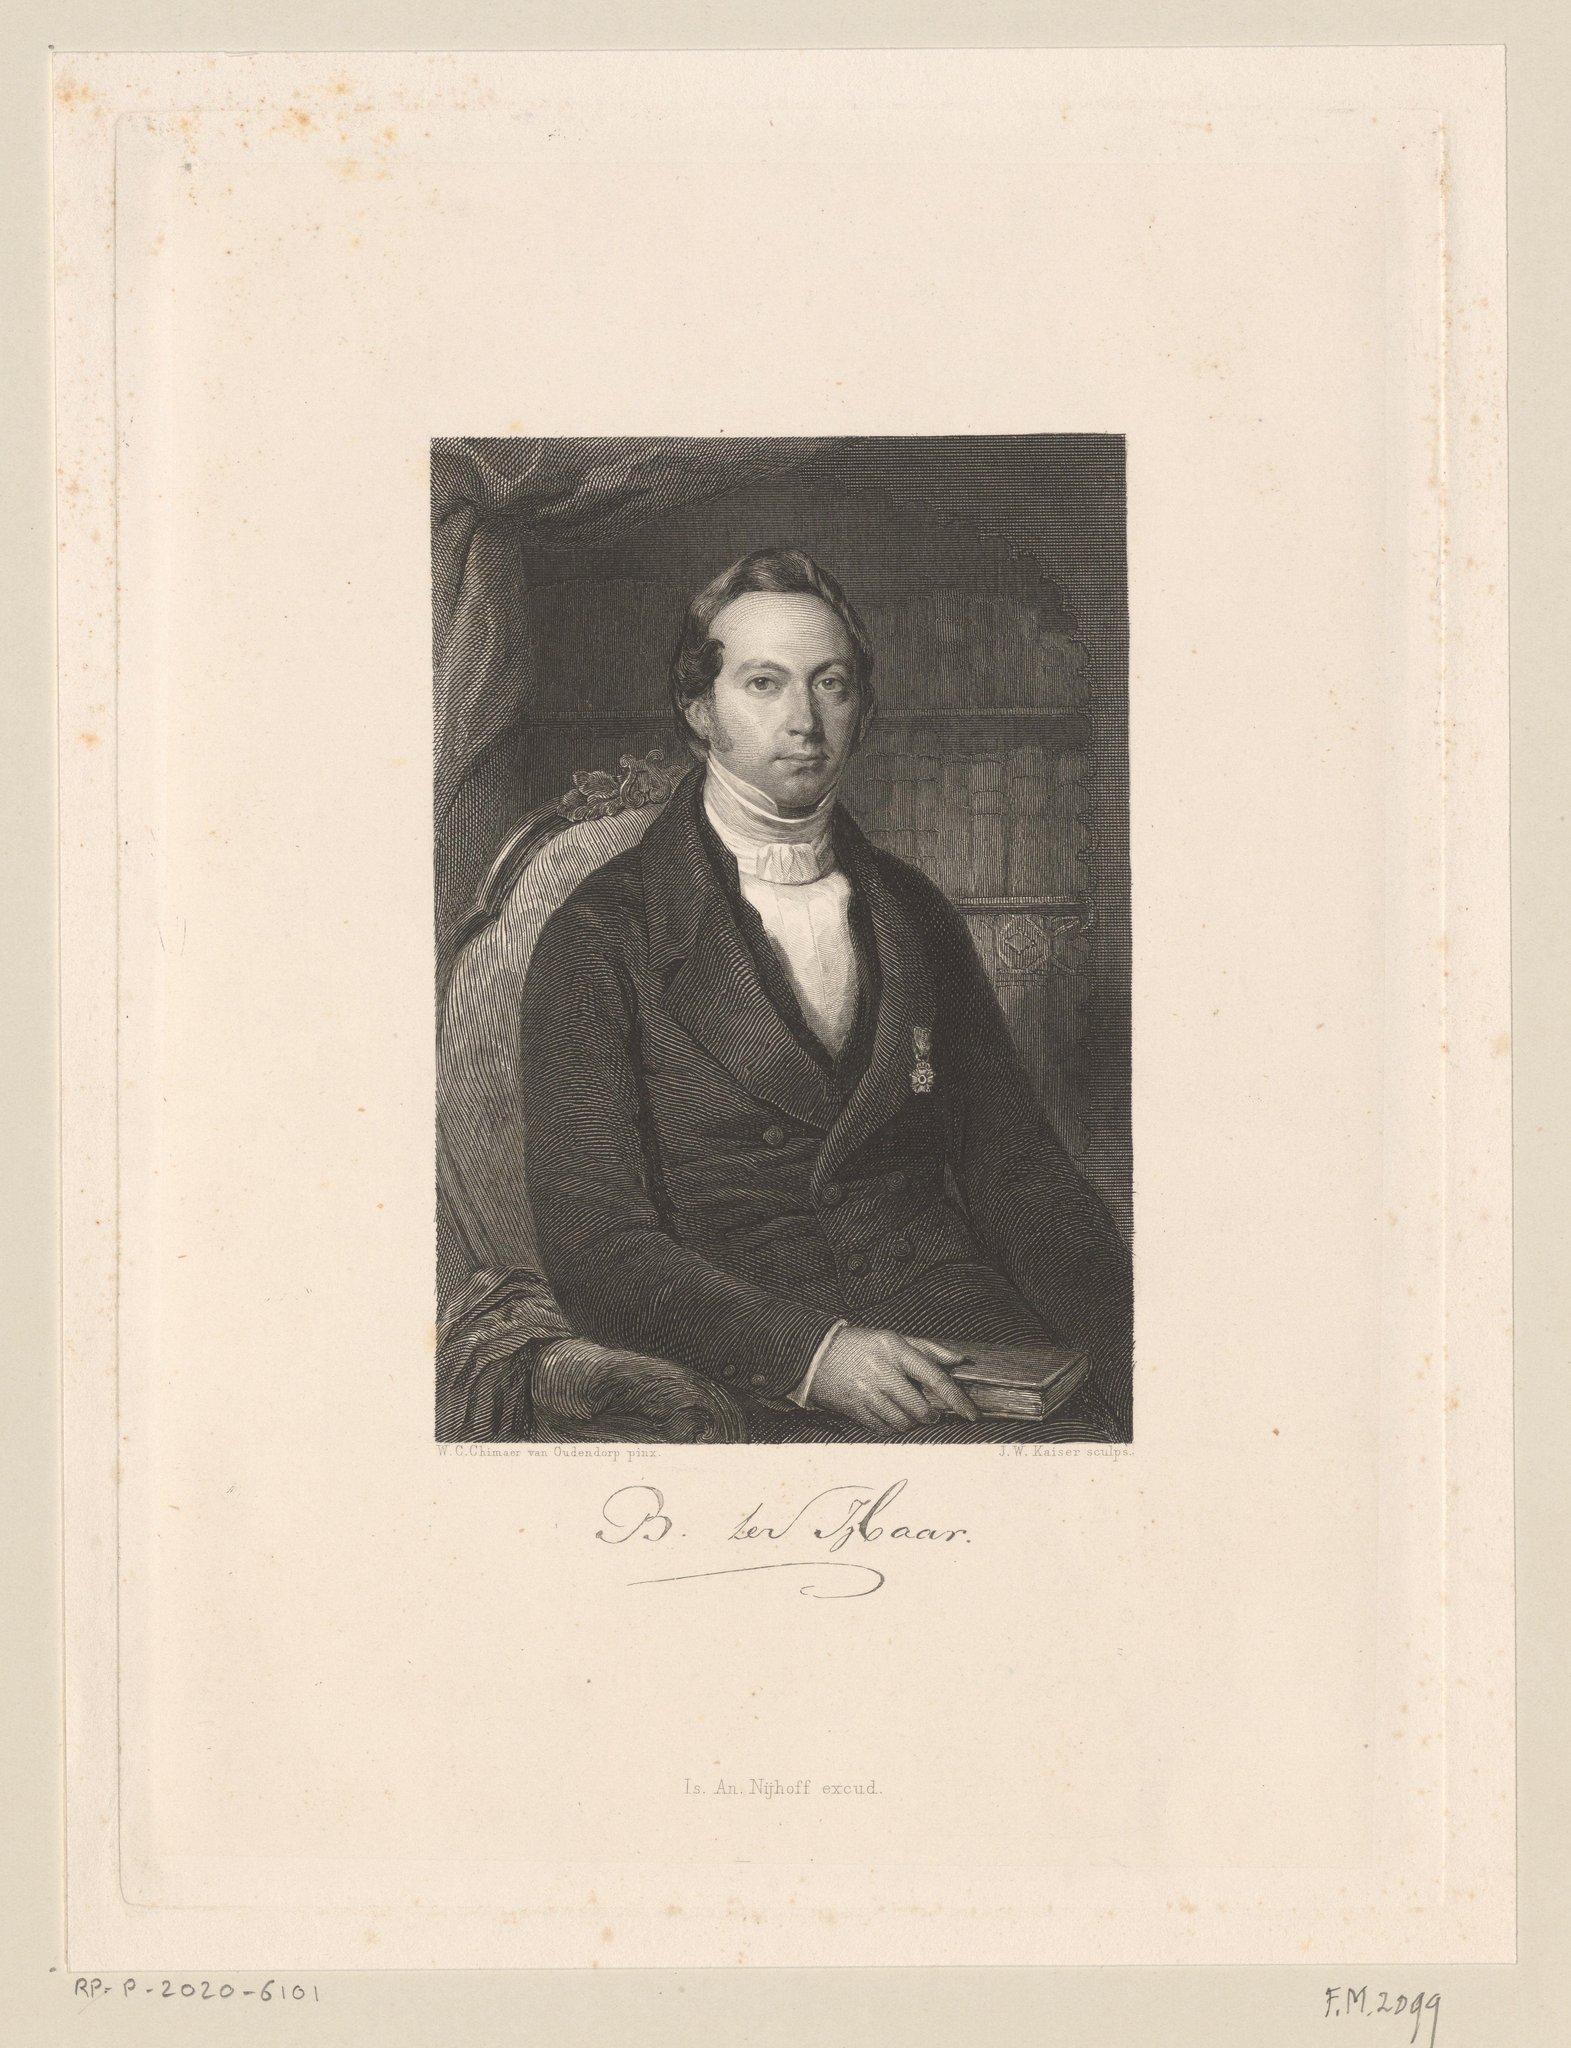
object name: print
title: Portret van Bernard ter Haar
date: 1830-1853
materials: paper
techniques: engraving, etching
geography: arnhem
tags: amsterdam, bernard ter haar, bookshelves, historical persons, book